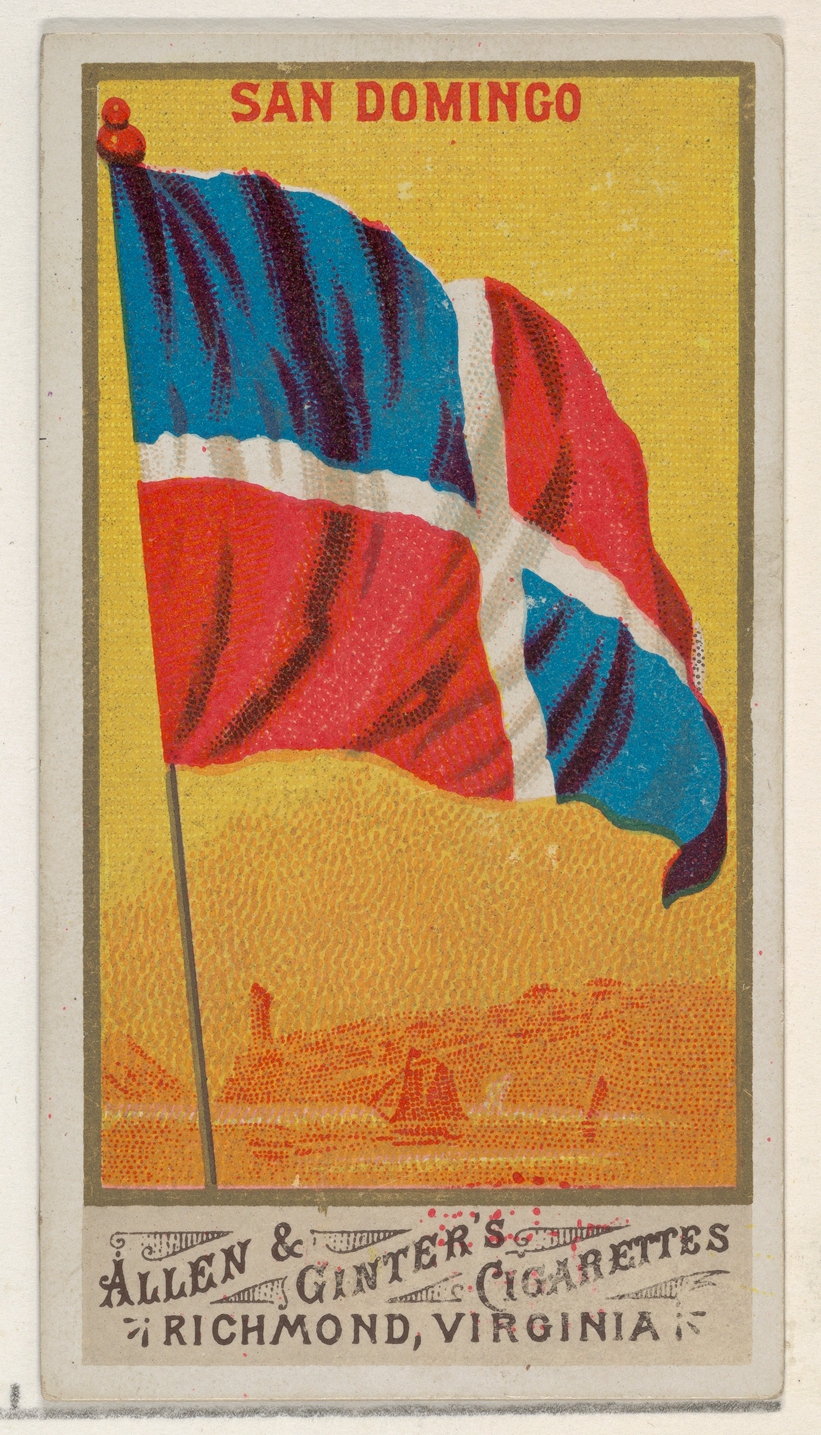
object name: print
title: San Domingo, from Flags of All Nations, Series 1 (N9) for Allen & Ginter Cigarettes Brands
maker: allen & ginter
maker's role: publisher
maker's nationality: american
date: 1887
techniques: color lithograph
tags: flags